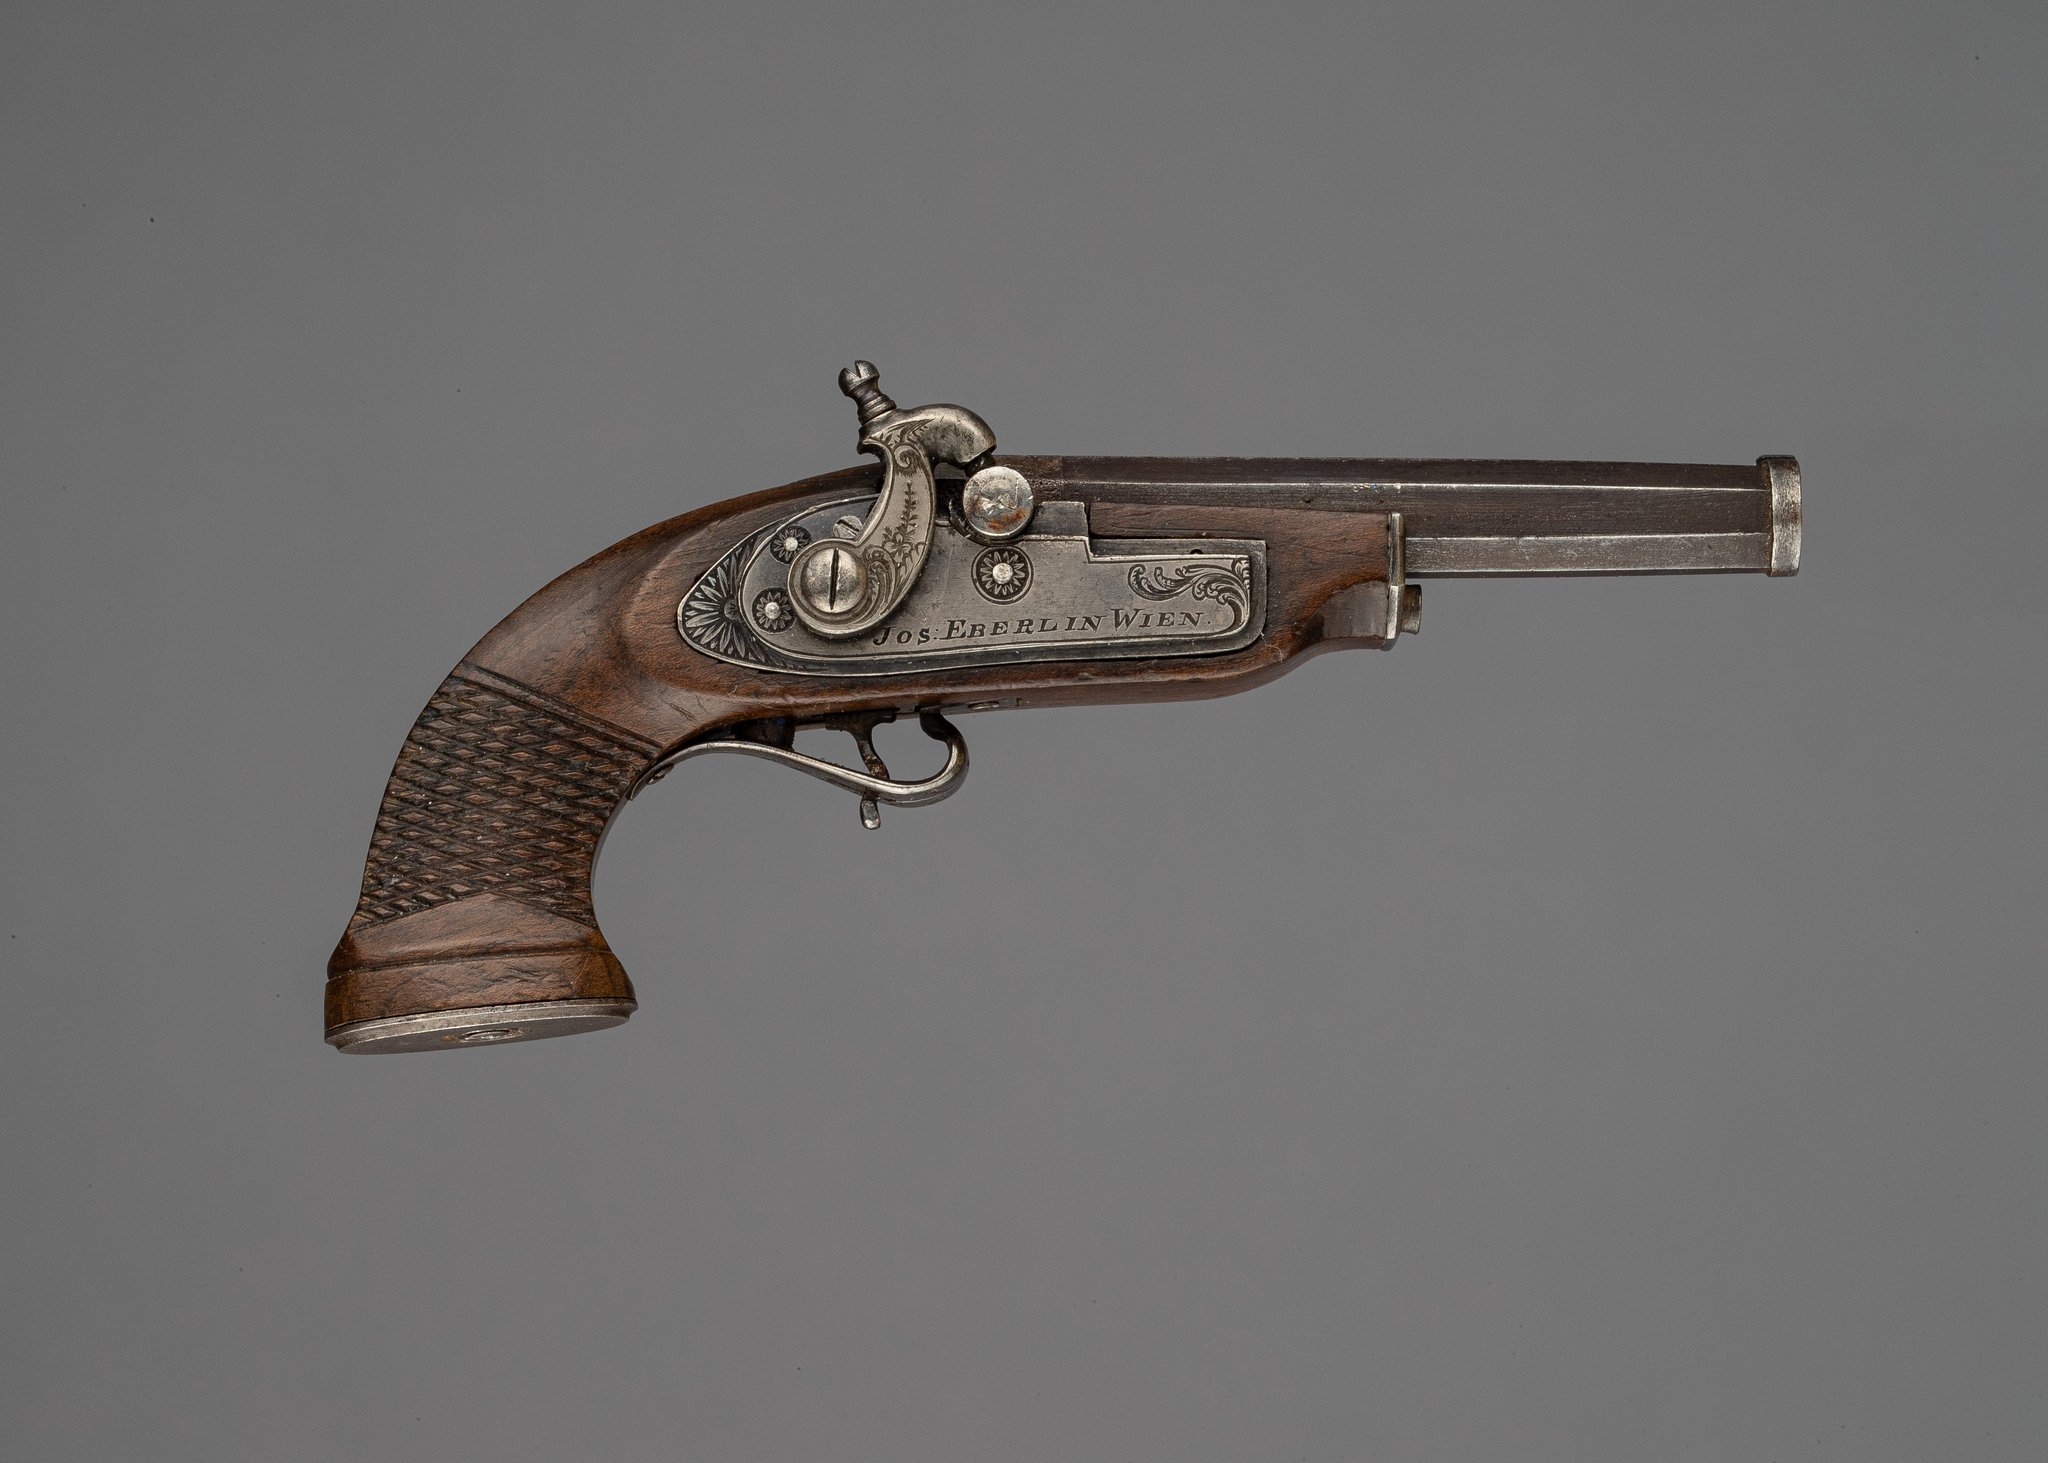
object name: model of percussion pistol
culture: austrian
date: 1801-1900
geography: austria